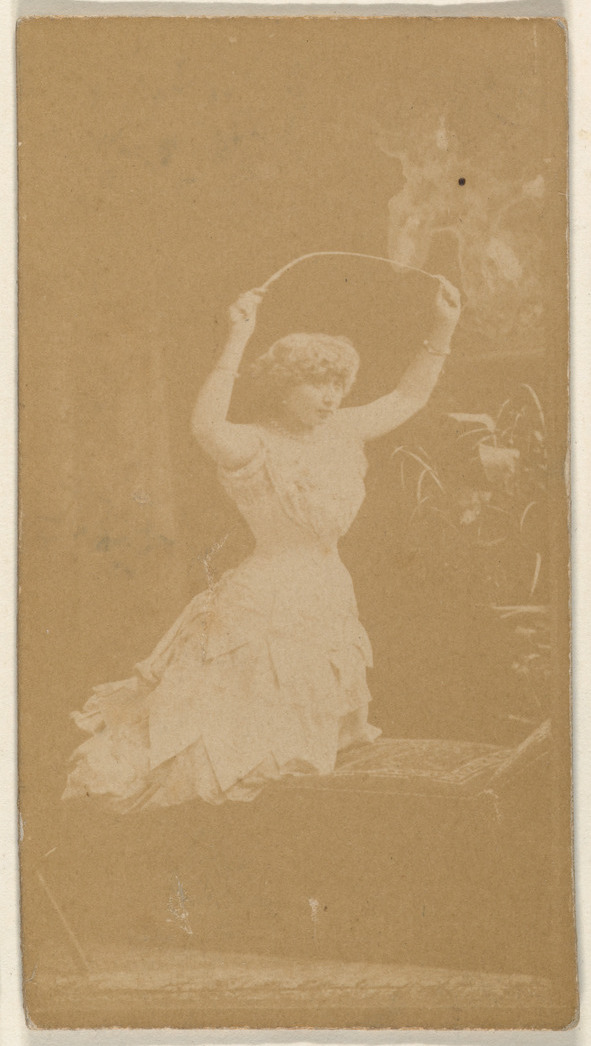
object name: photograph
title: Actress holding riding crop above head, from the Actresses series (N668)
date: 1888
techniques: albumen silver print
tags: portraits,women,actresses